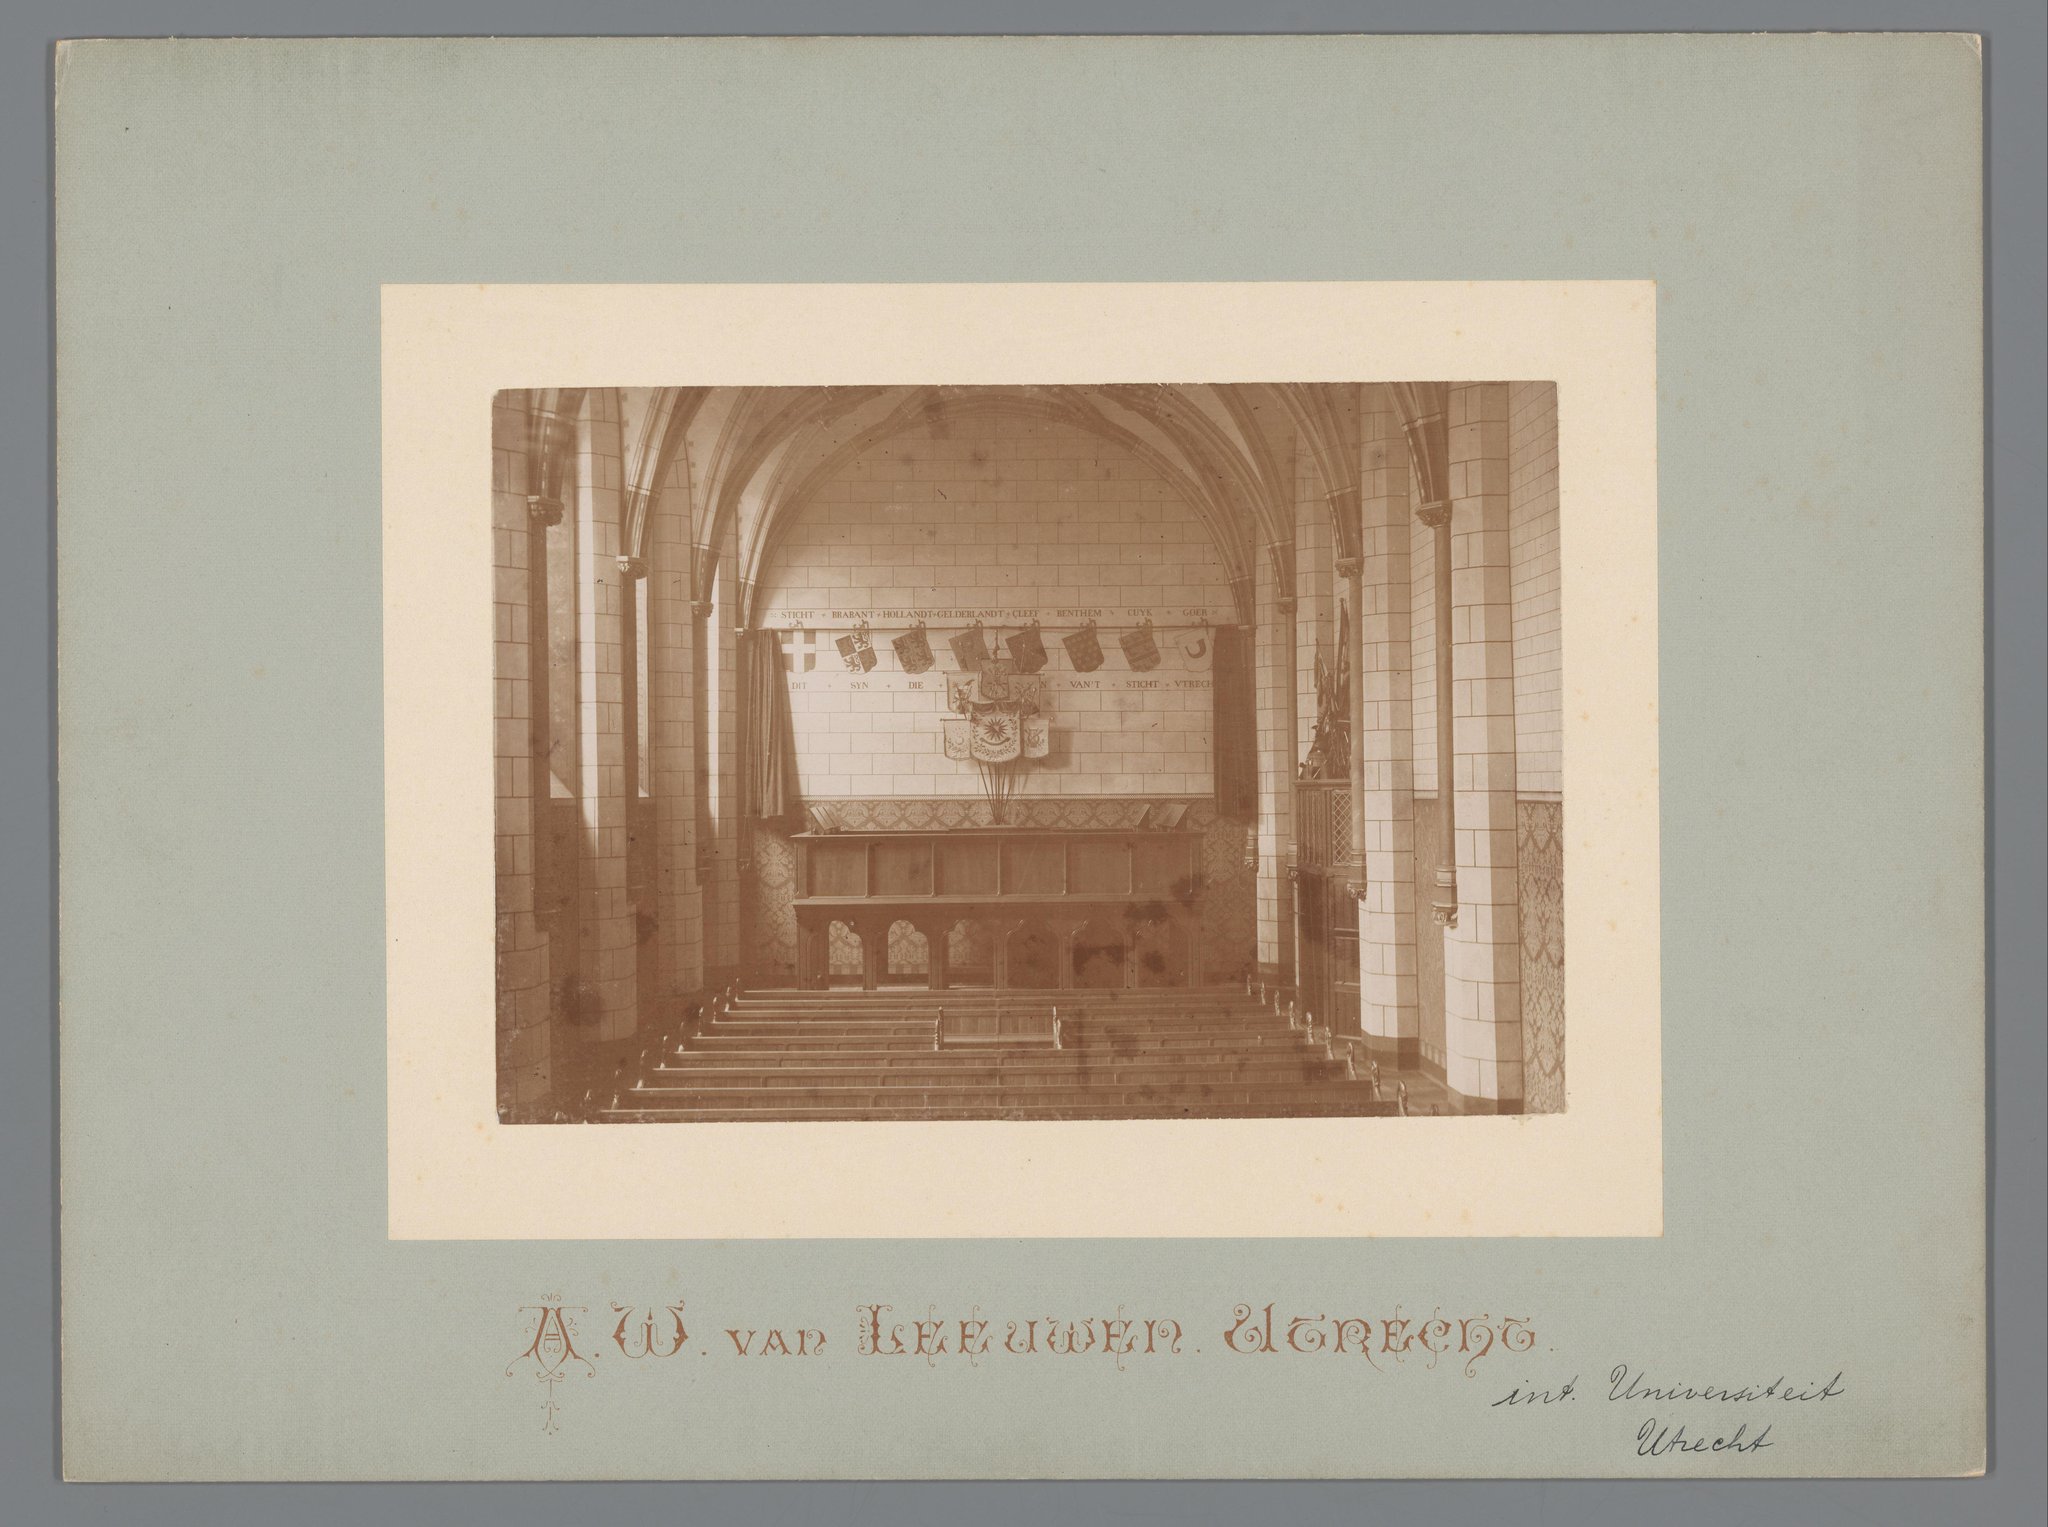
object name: photograph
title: Interieur van een zaal van de Universiteit van Utrecht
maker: a.w. van leeuwen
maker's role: fotograaf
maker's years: 1868-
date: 1880-1909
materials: cardboard, photographic support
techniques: collodion silver print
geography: utrecht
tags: university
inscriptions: collector's mark: Lugt 2228, annotation: ‘int. Universiteit Utrecht’, inscription: ‘A.W. van Leeuwen. Utrecht’, retailer's mark: ‘G. Hilhorst A zn/ Acad boek en kunsthandel/ Algem. Muziekh./ Domsteeg F.1/ Utrecht’, number: ‘09' 80’